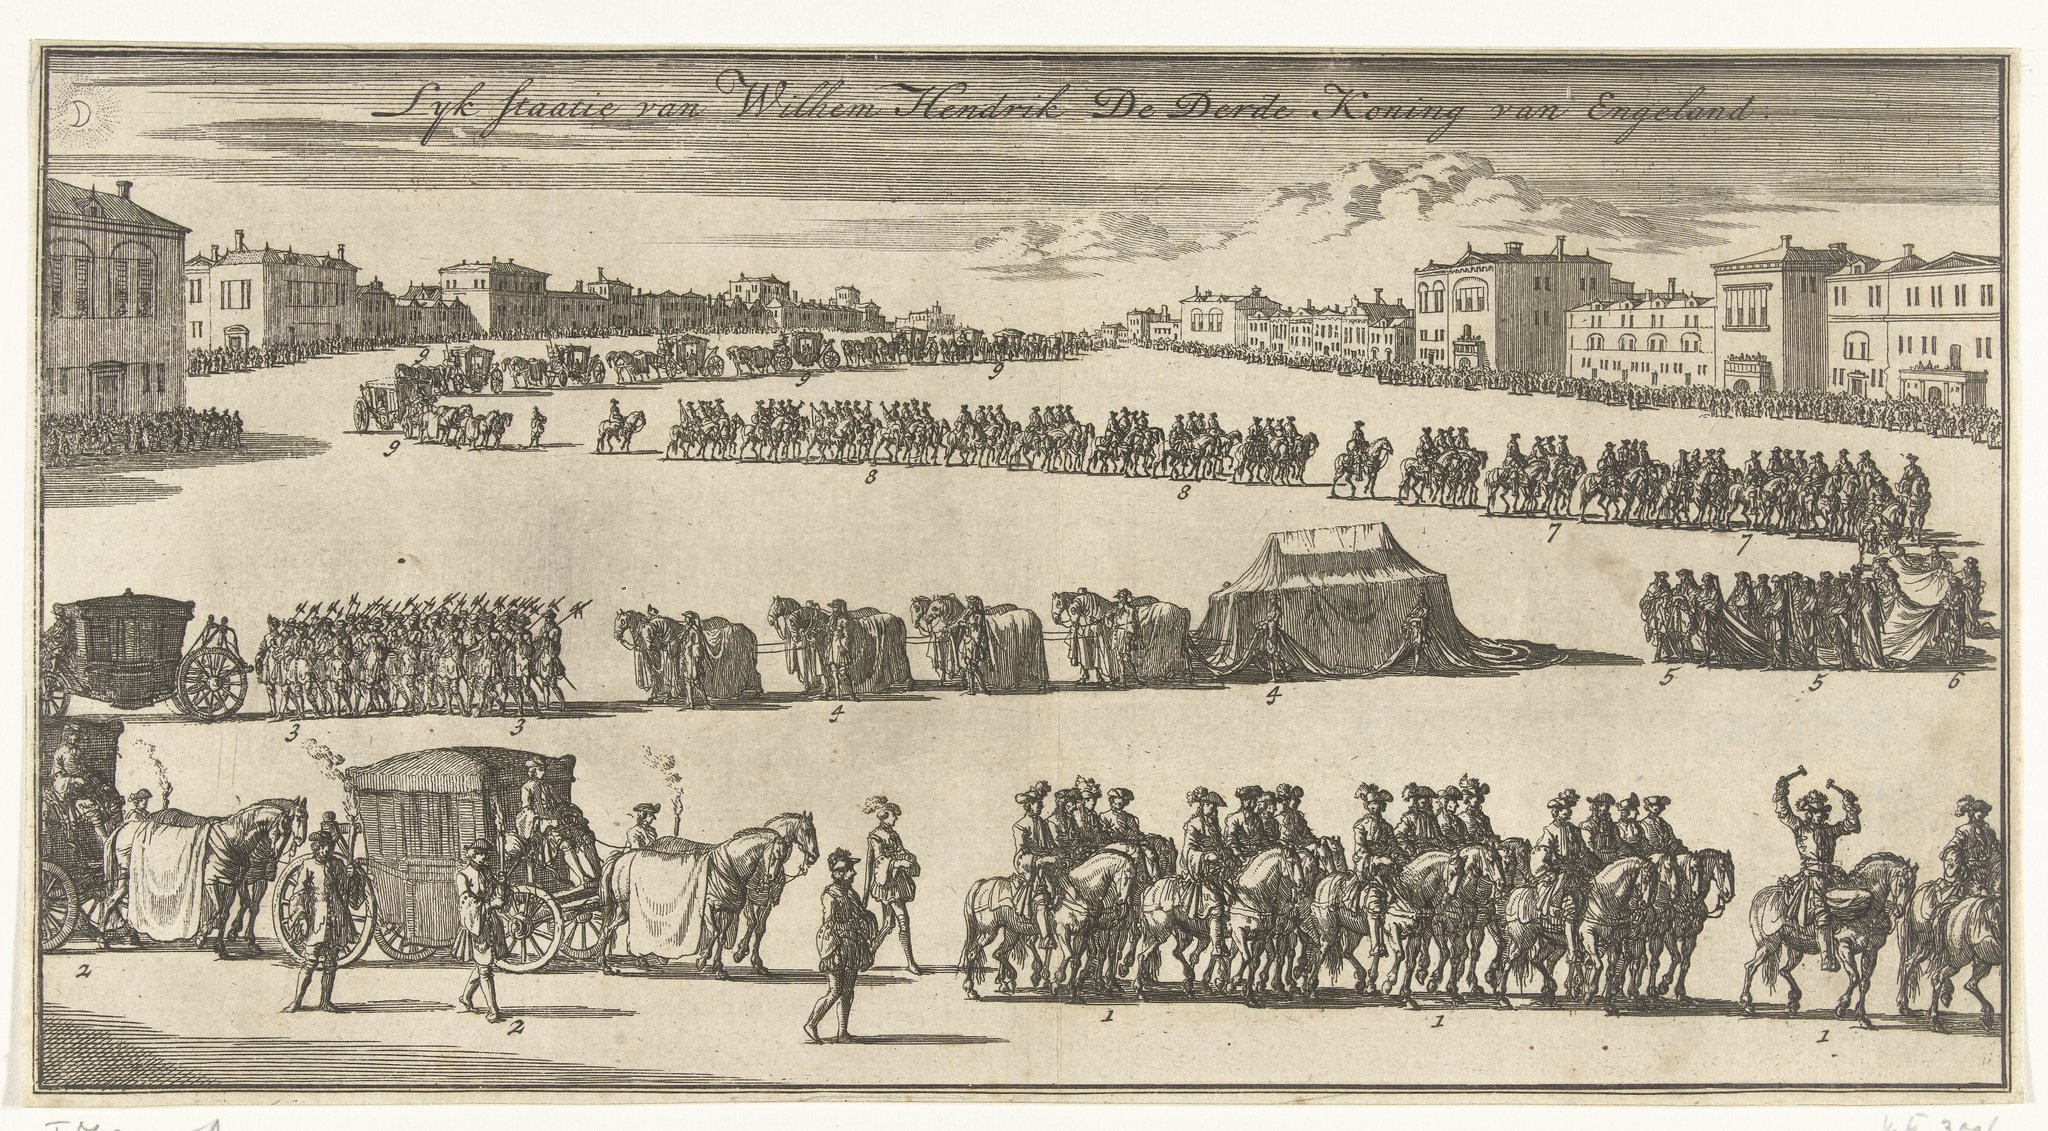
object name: print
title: Begrafenis van Willem III, 1702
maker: jan luyken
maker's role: draughtsman, print maker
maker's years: 1649-1712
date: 1702-1703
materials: paper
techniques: etching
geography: northern netherlands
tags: the hague, william iii (prince of orange and king of england, scotland, and ireland), cortege, funeral procession, london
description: Gebruikt als illustratie in: A. Montanus, Het leven, bedryf, en oorlogs-daaden van Wilhem den Derden, Jan Claesz ten Hoorn, Amsterdam 1703, dl. IV.